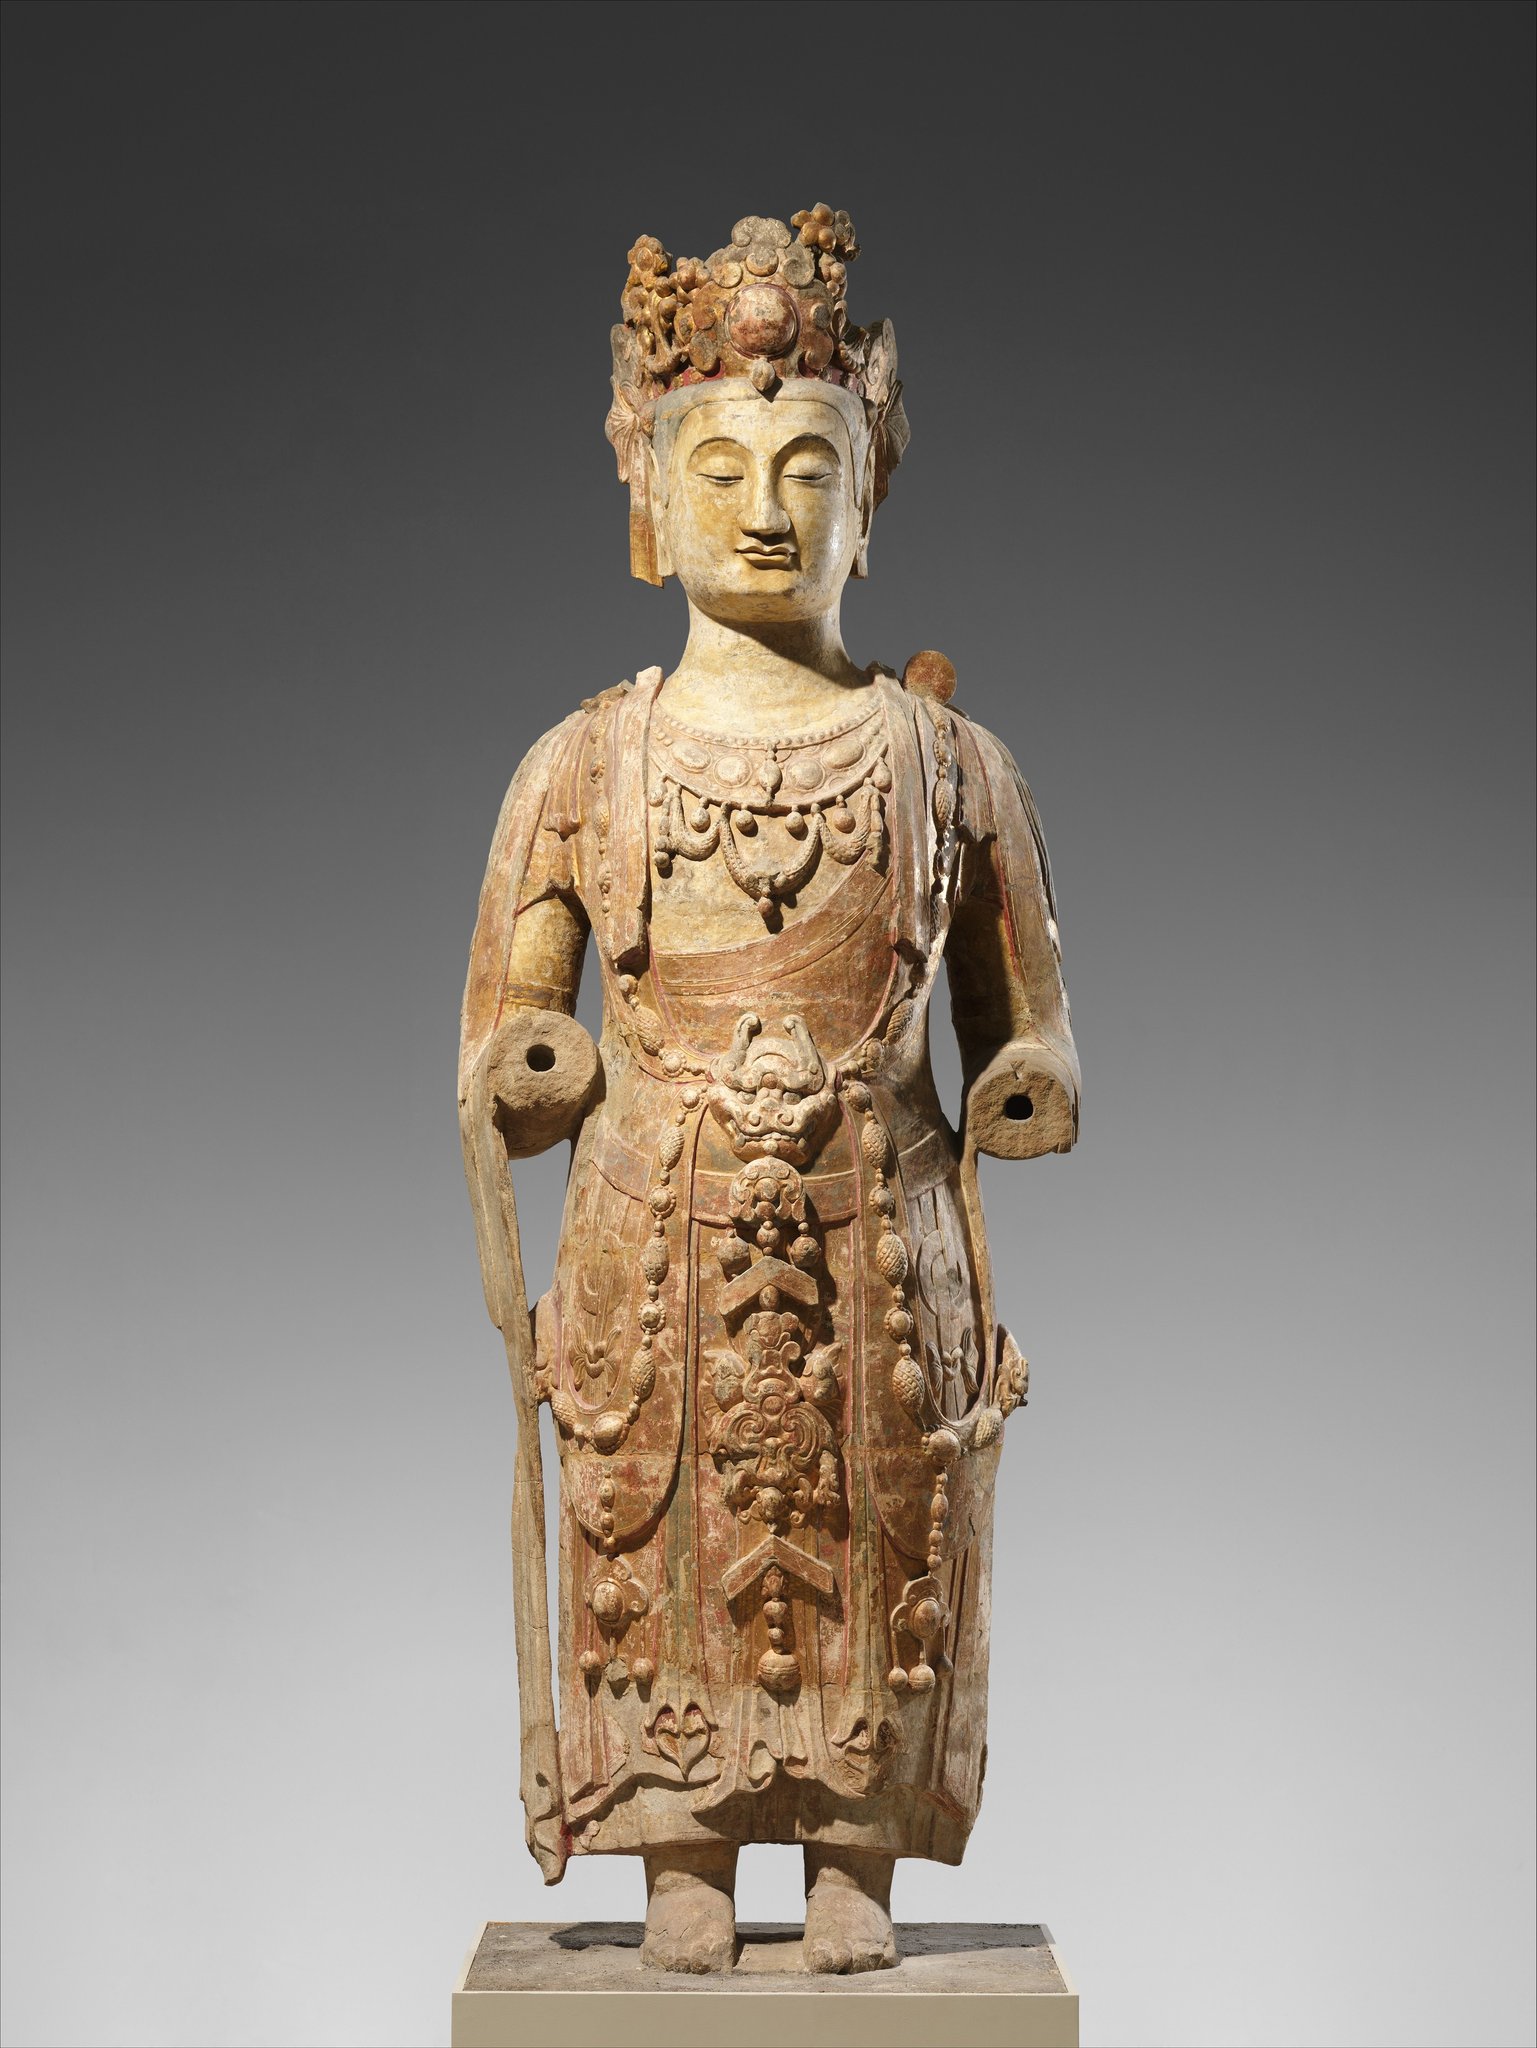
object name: figure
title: Bodhisattva, probably Avalokiteshvara (Guanyin)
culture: chinese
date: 550-560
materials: pigment, stone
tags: buddhism,avalokiteshvara,bodhisattvas